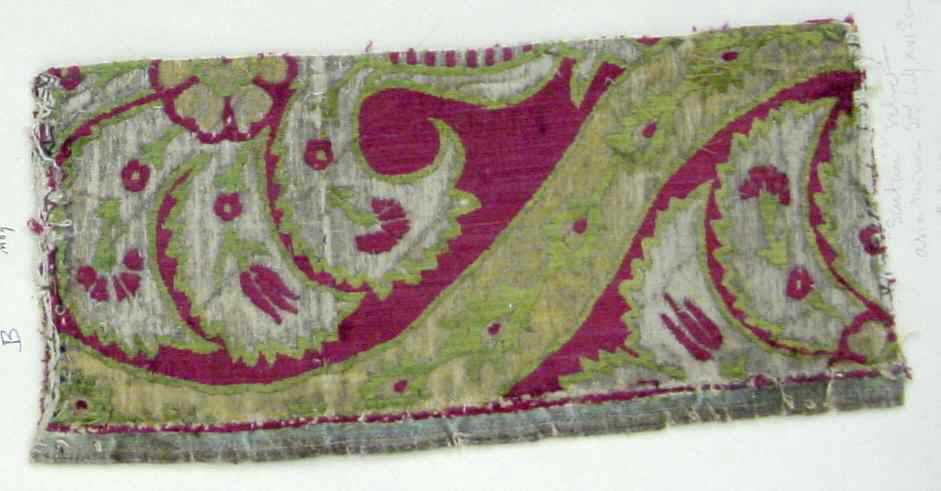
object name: textile fragment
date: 1551-1600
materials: metal thread, silk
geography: turkey